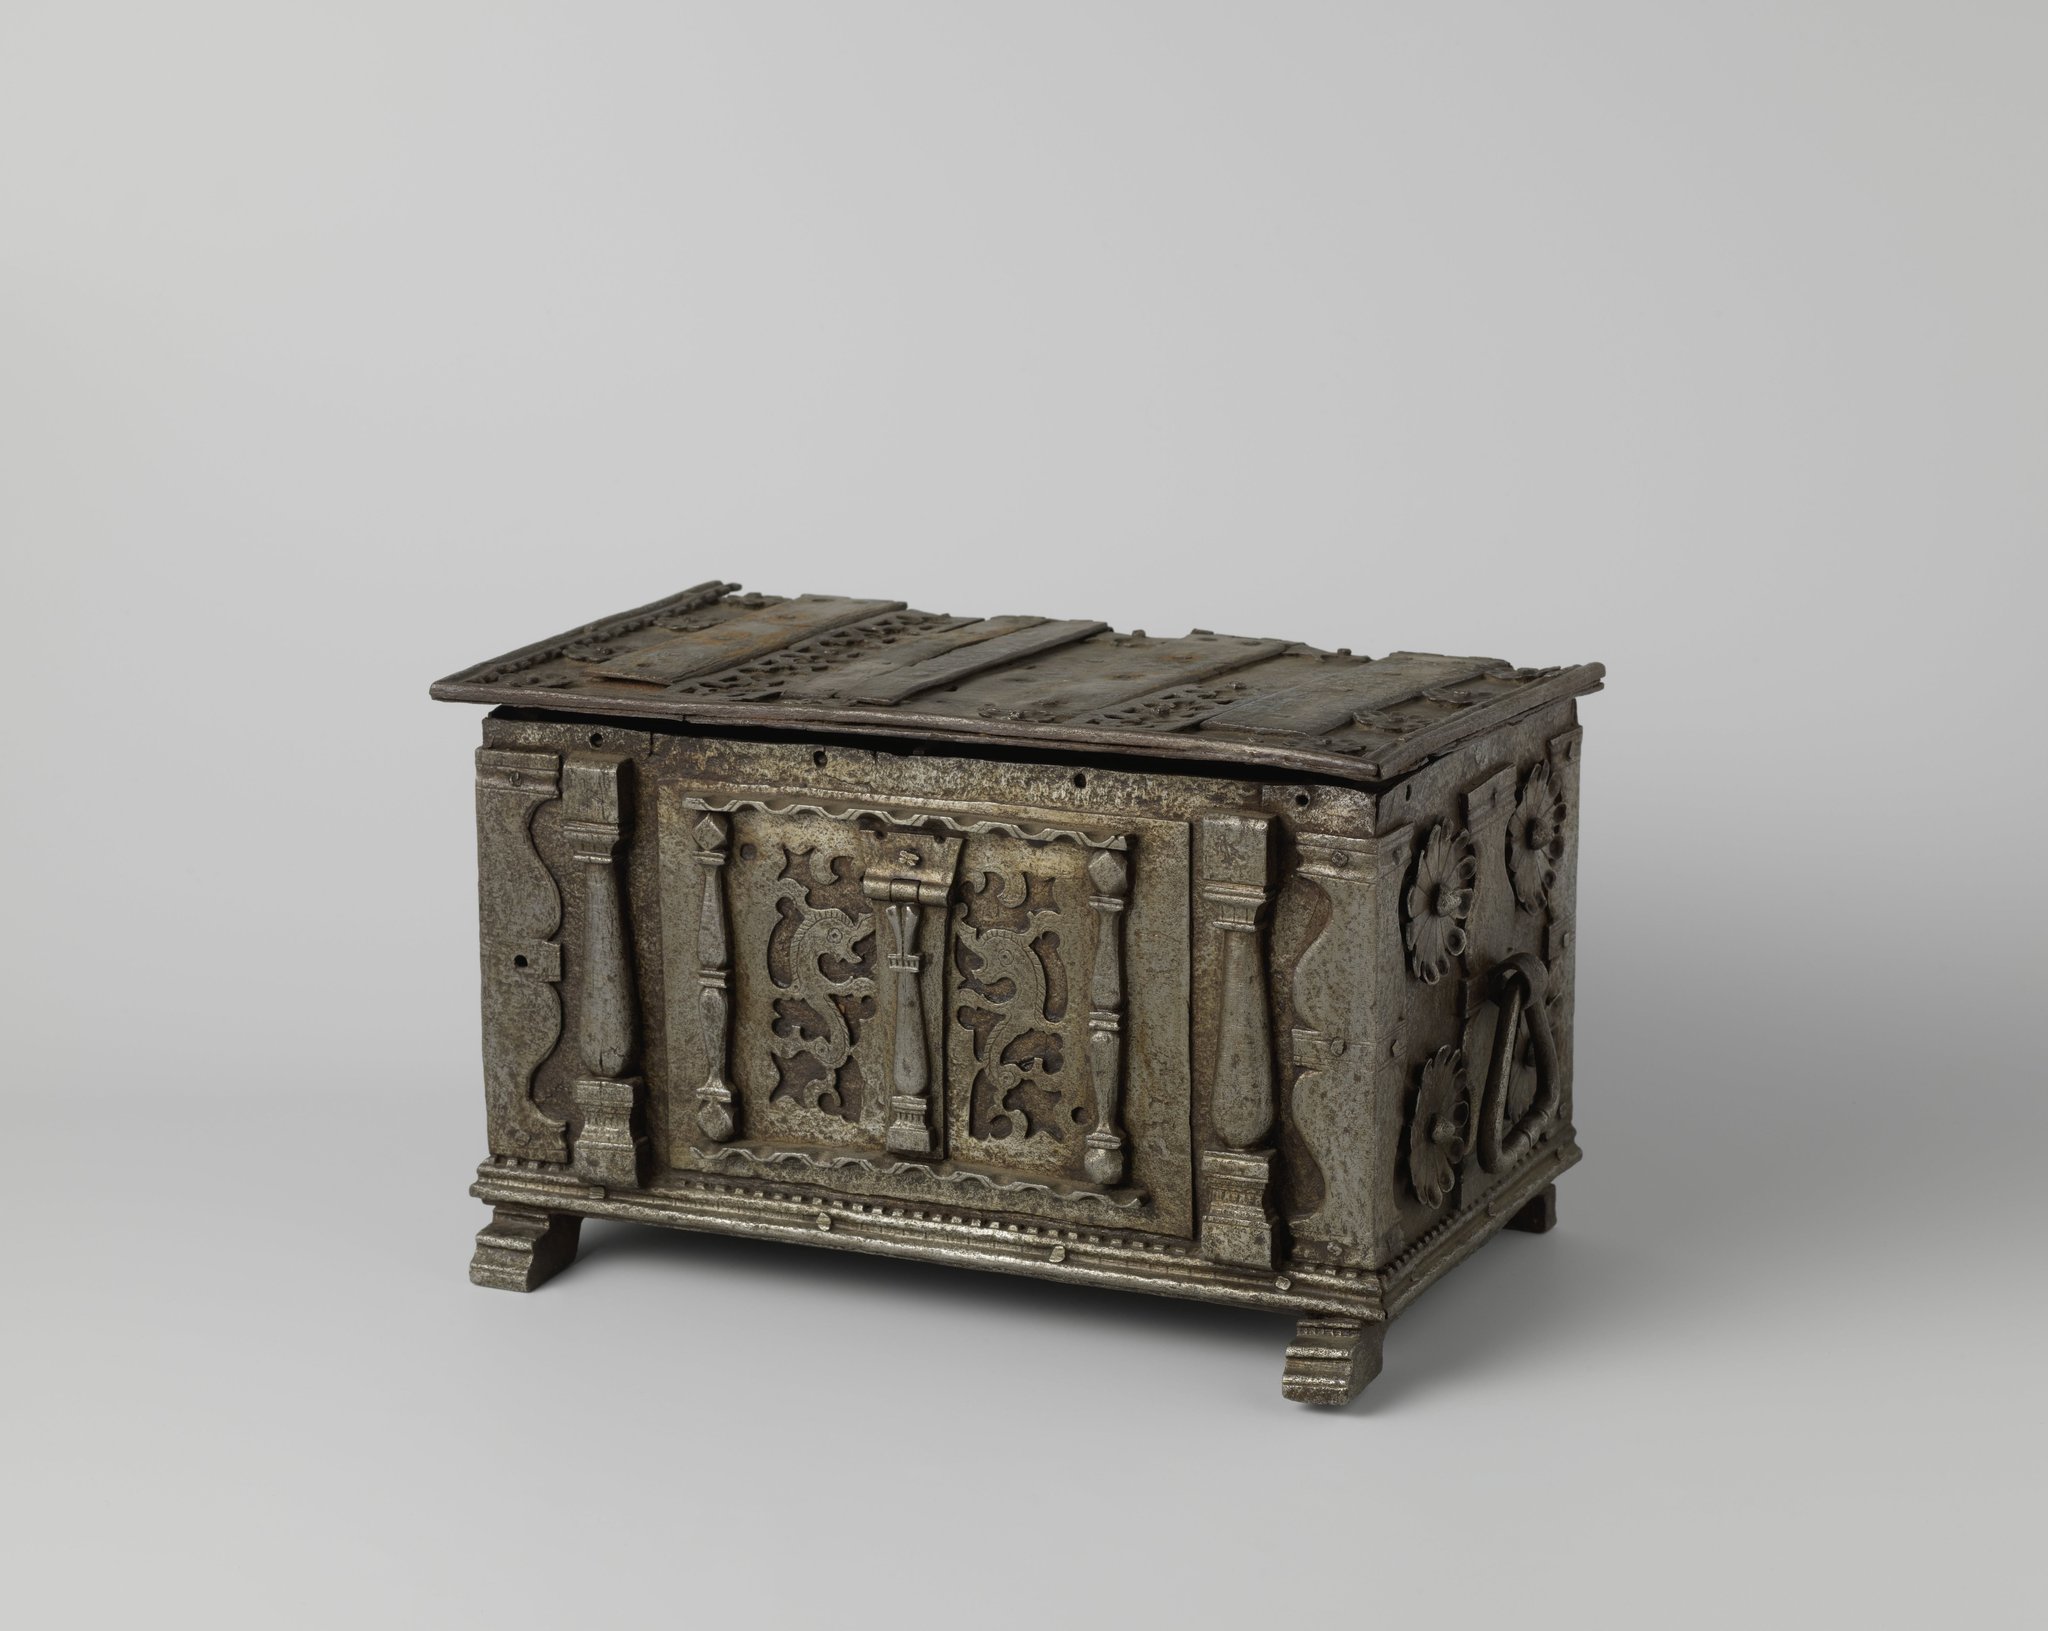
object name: chest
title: IJzeren kist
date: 1500-1600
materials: iron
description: Een vierkant ijzeren kist met dubbel verborgen slot en twee hengsels. De sleutels ontbreken.